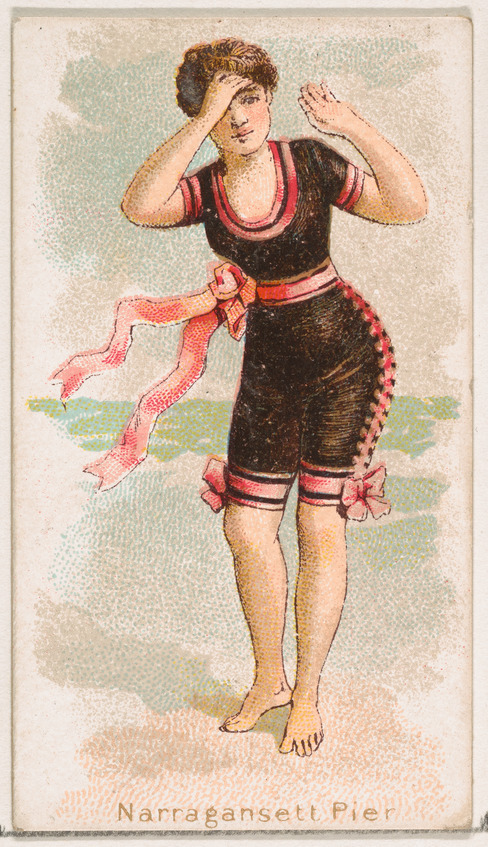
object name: print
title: Narragansett Pier, from the Fancy Bathers series (N187) issued by Wm. S. Kimball & Co.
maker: william s. kimball & company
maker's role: publisher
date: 1889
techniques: color lithograph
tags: women